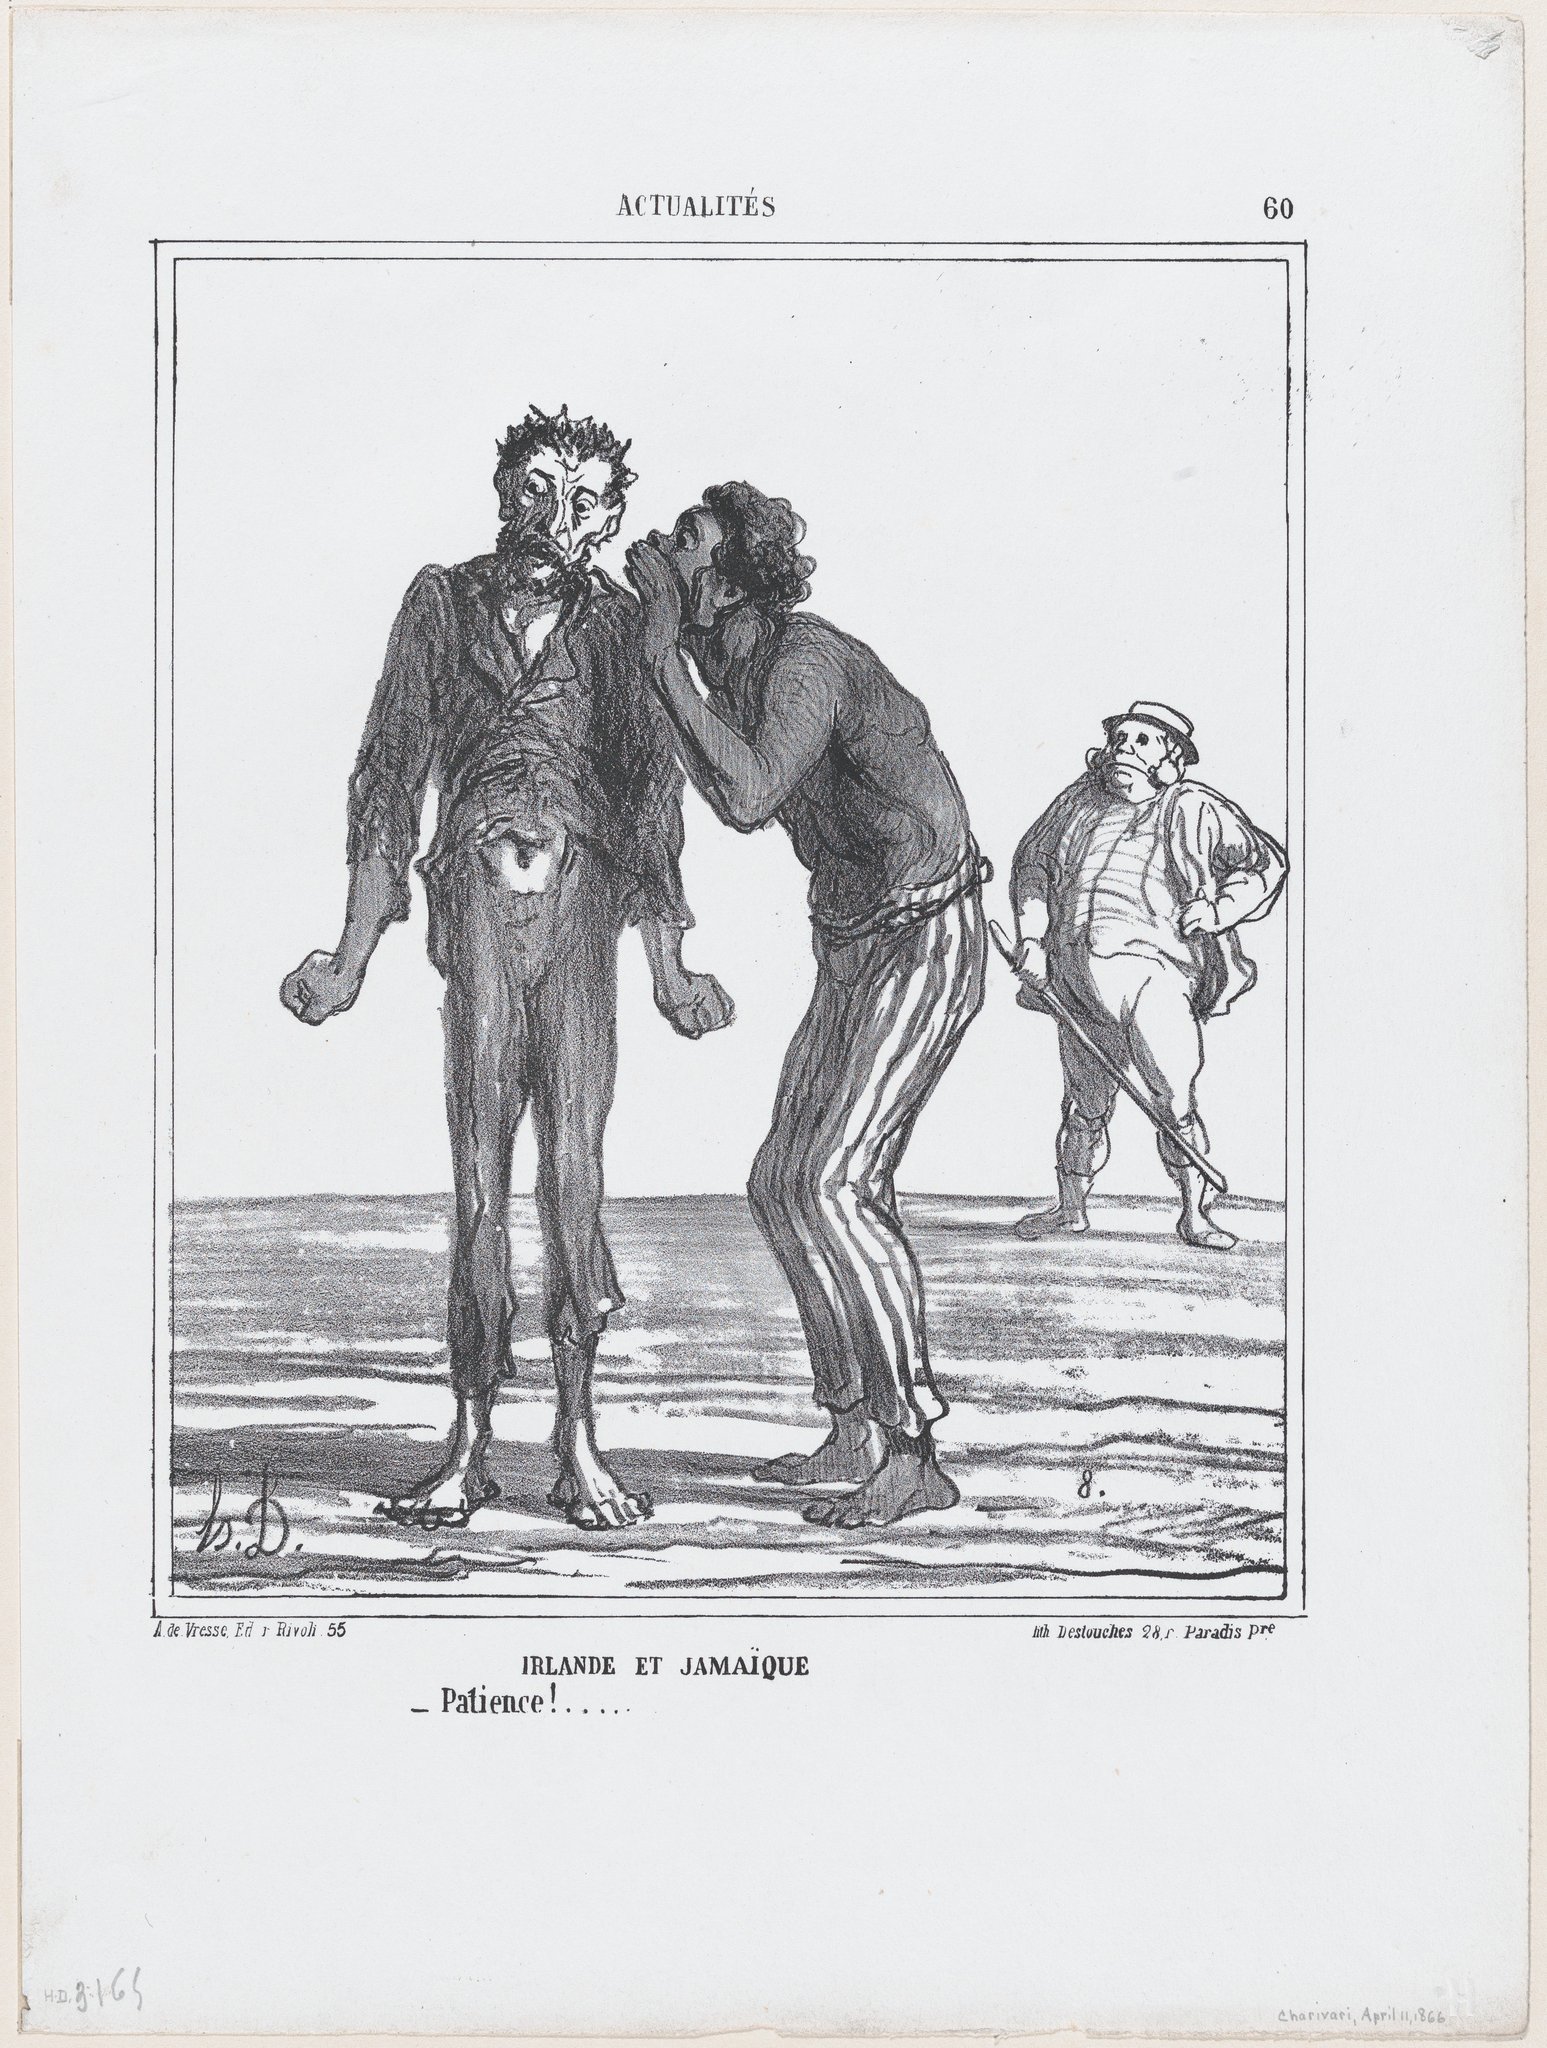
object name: print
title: Ireland and Jamaica: Patience!, from 'News of the day,' published in "Le Charivari"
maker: honoré daumier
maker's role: artist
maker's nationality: french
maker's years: 1808-1879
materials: paper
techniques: lithograph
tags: satire,men